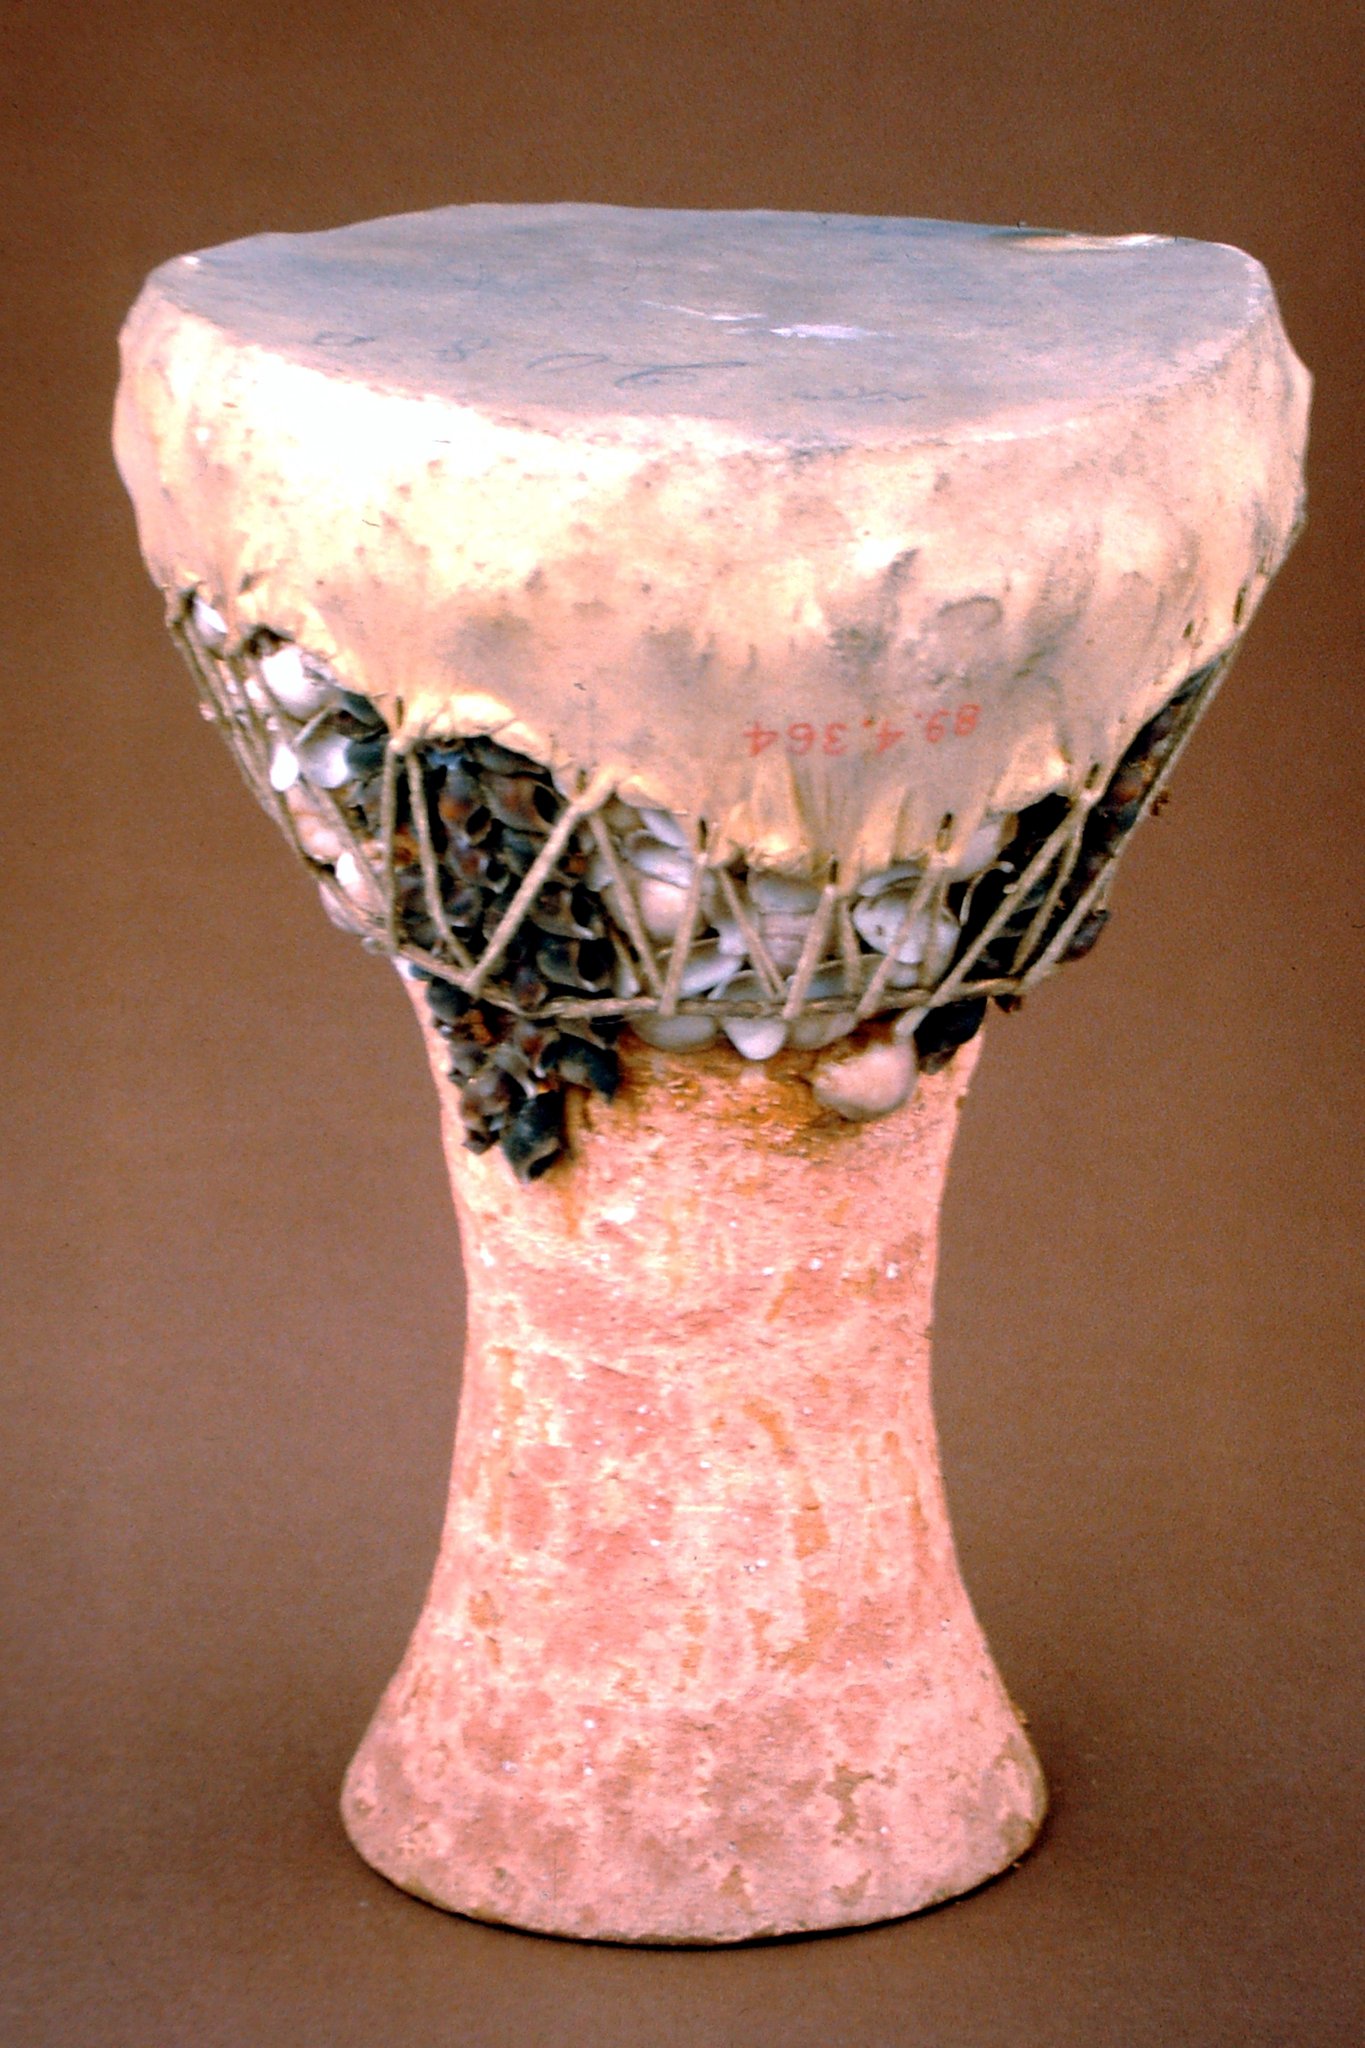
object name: daraboukkeh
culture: arabian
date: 1801-1900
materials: pottery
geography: arabia